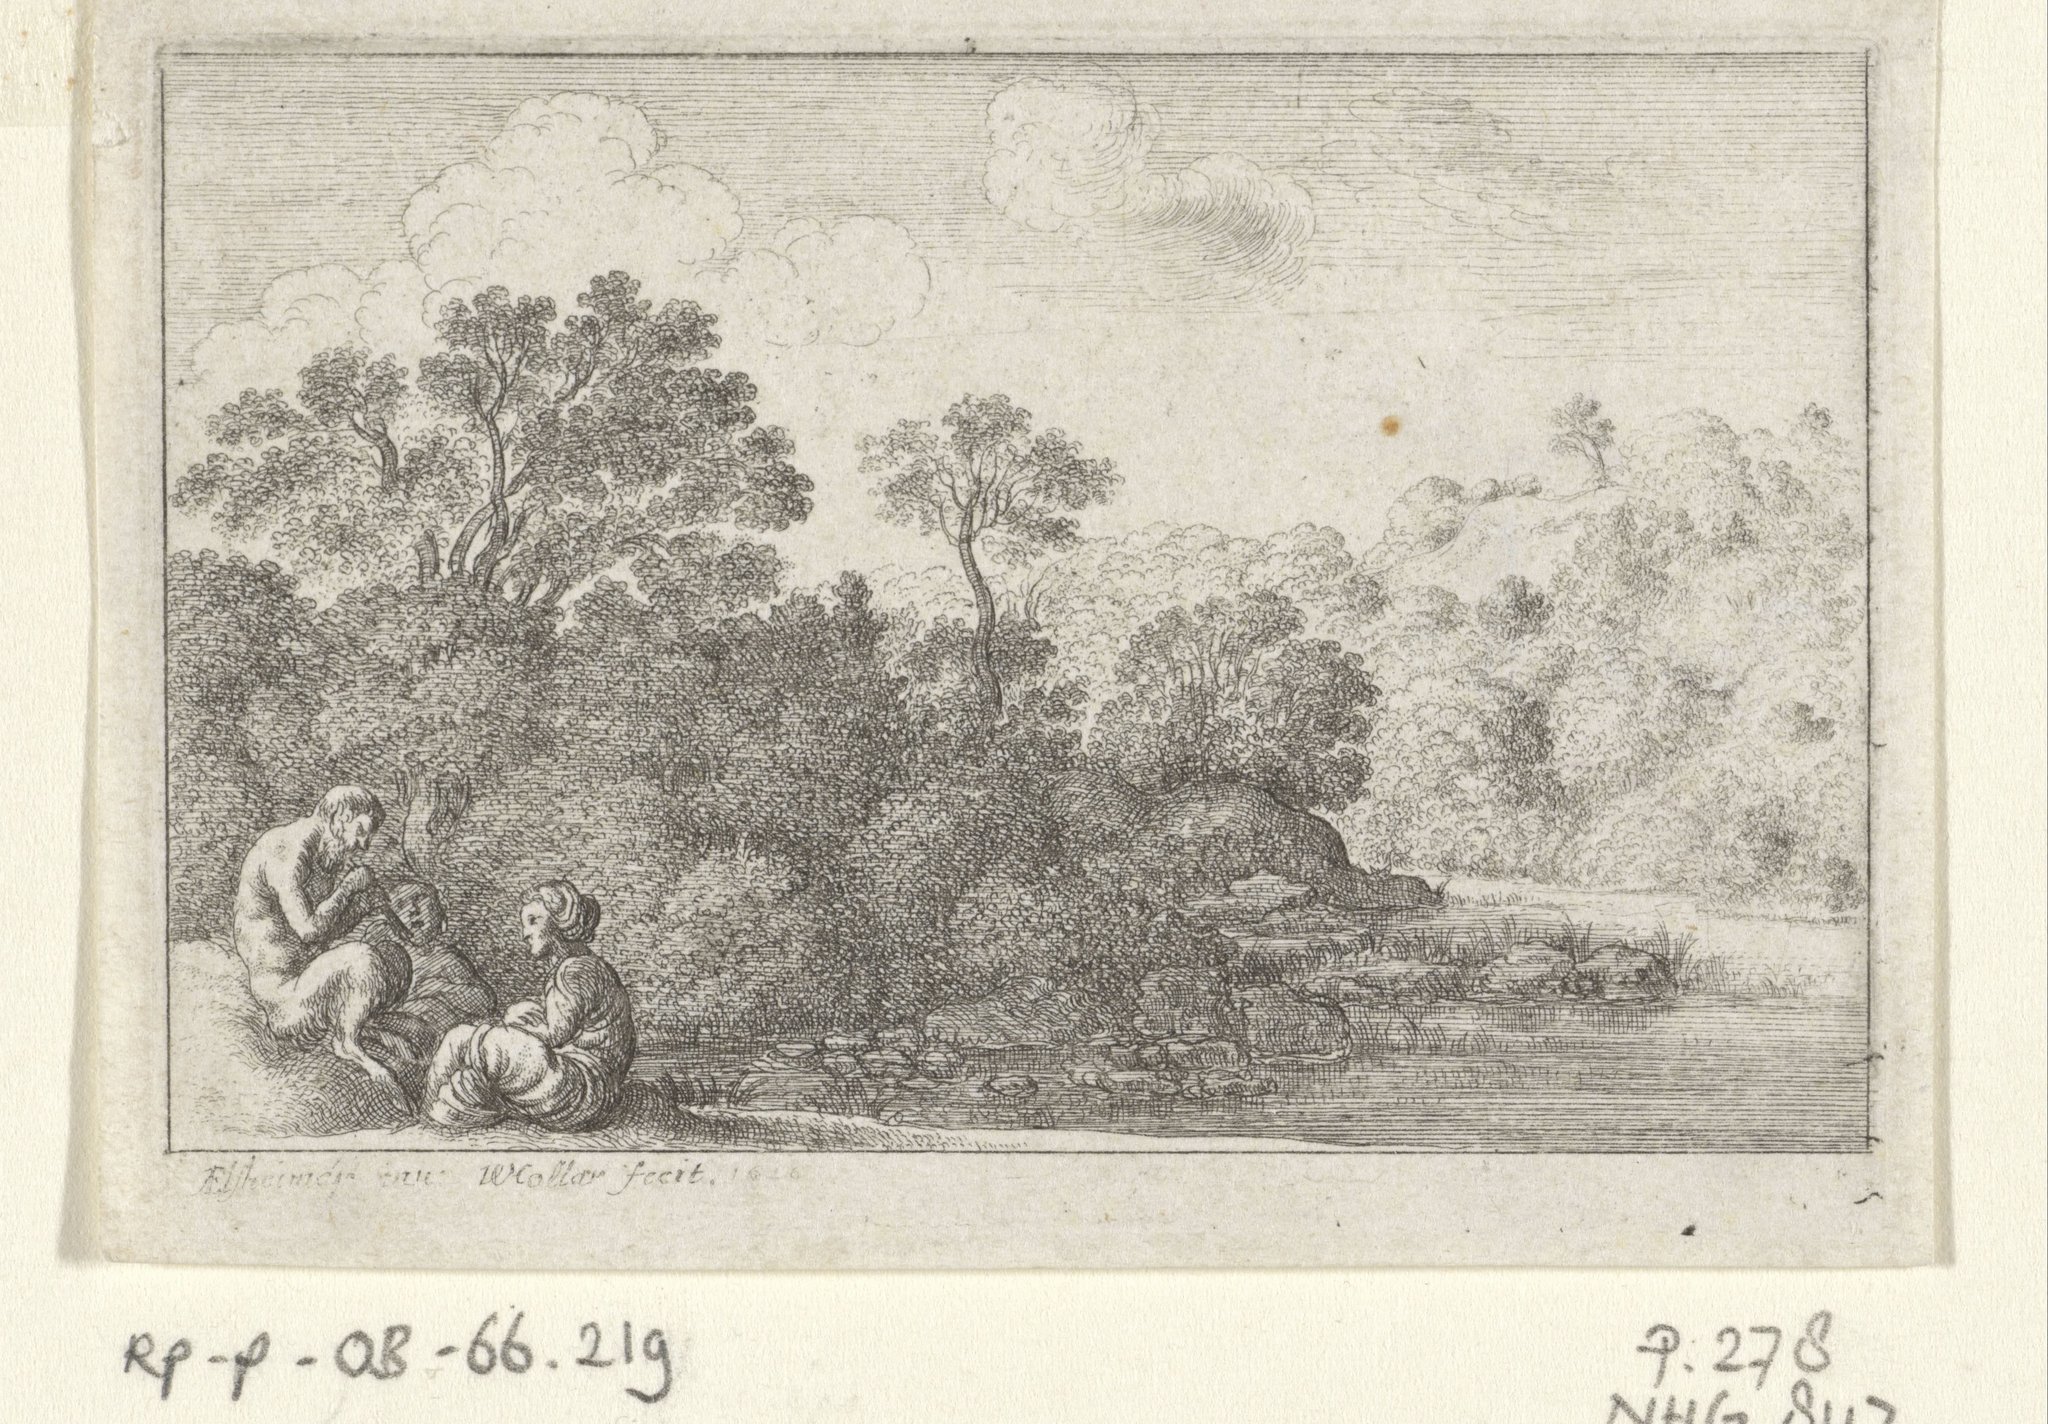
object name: print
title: Sater met twee nimfen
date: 1646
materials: paper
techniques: etching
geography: antwerp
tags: non-aggressive, friendly or neutral activities and relationships of satyr(s), nymphs (in general); 'ninfe in commune' (ripa)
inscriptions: collector's mark: Lugt 240